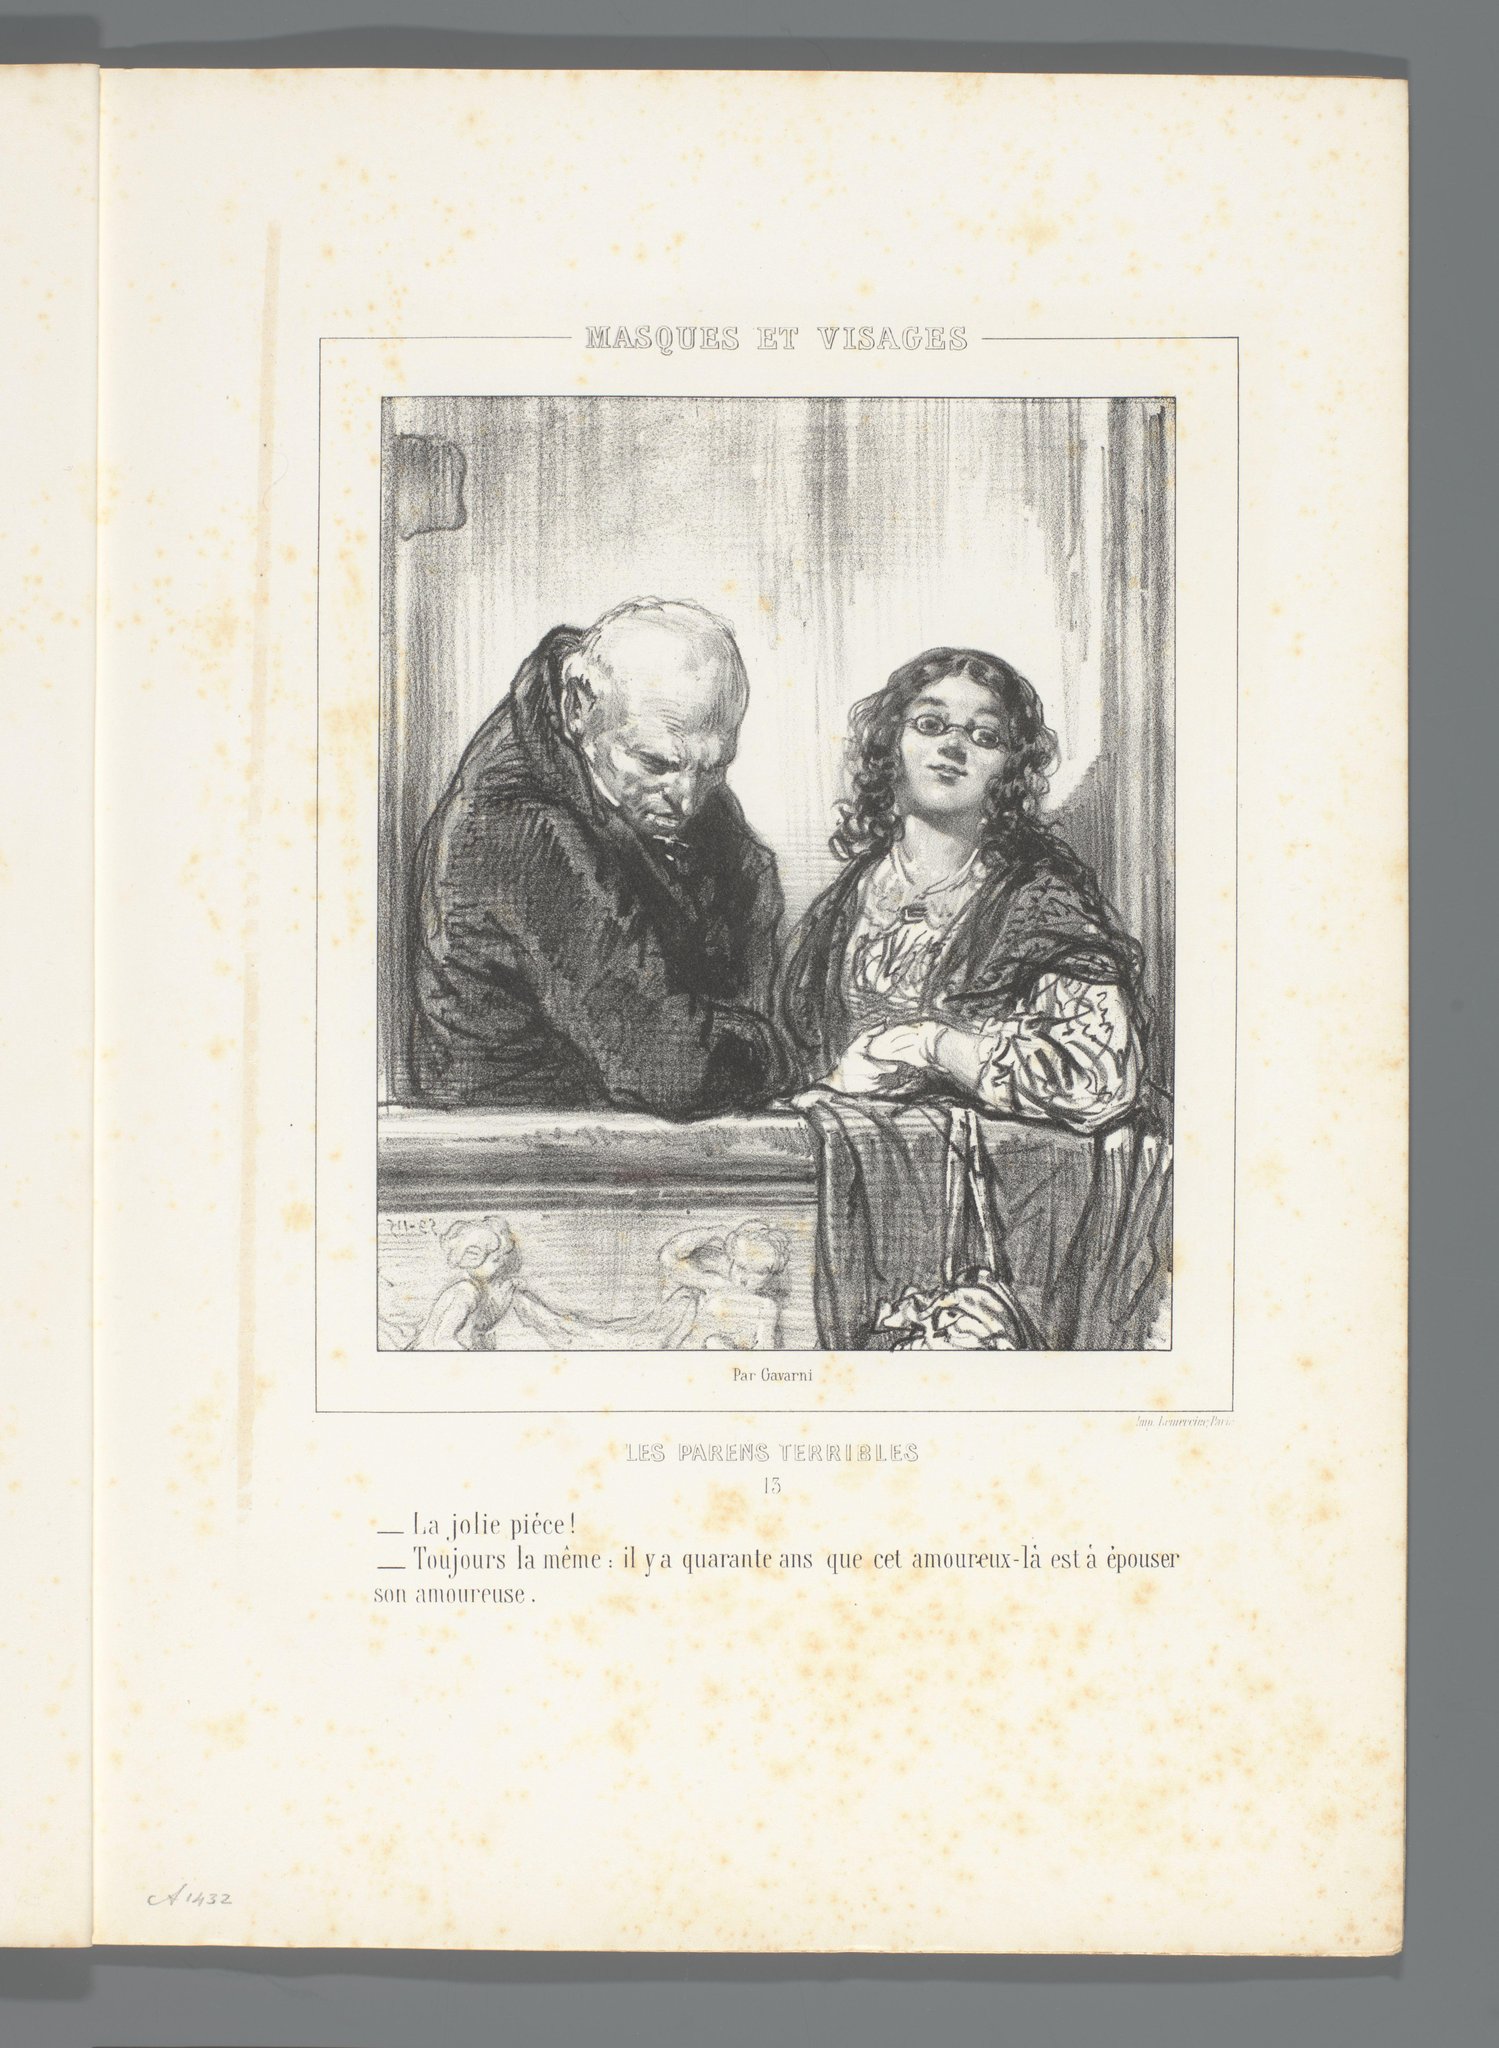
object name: album leaf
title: Vader houdt hand vast van zijn dochter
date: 1853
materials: paper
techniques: lithograph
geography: paris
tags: adolescent, young woman, maiden, old man, father and daughter(s) (family group) (with number of daughters)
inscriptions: collector's mark: Lugt 2228a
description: Prent gebruikt voor: Paris (Journal), juni 1853.